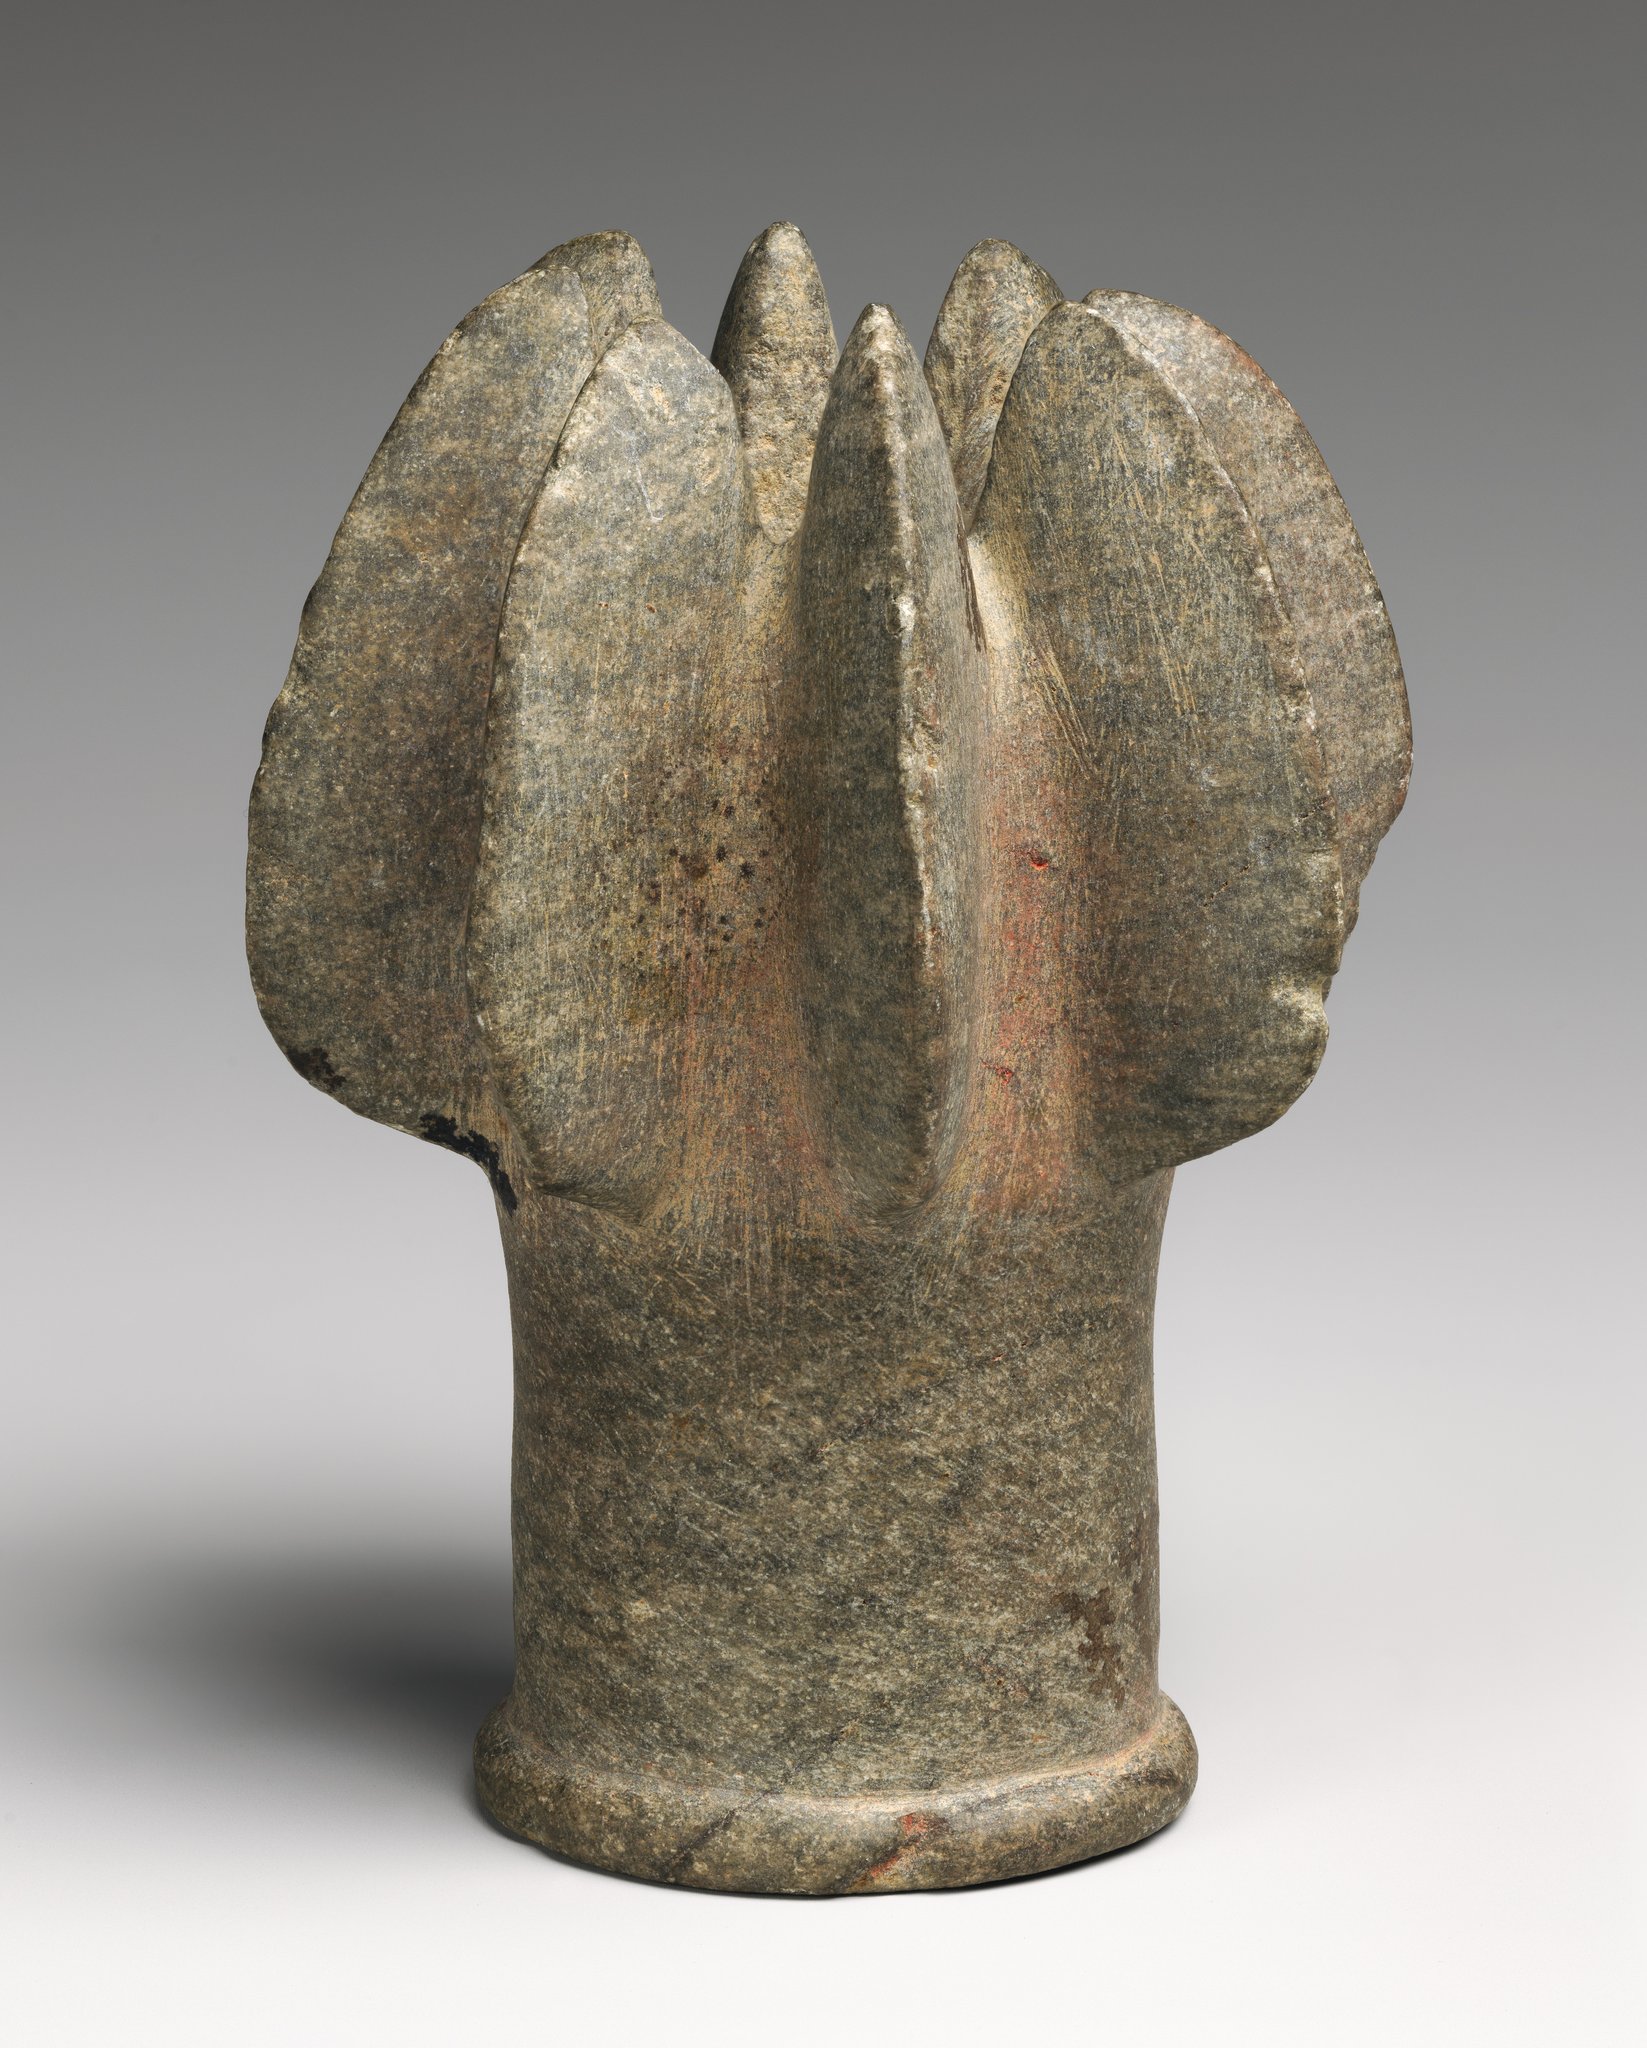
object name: mace head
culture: salinar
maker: salinar artist(s)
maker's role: artist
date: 450-150 BCE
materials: pigment, stone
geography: peru